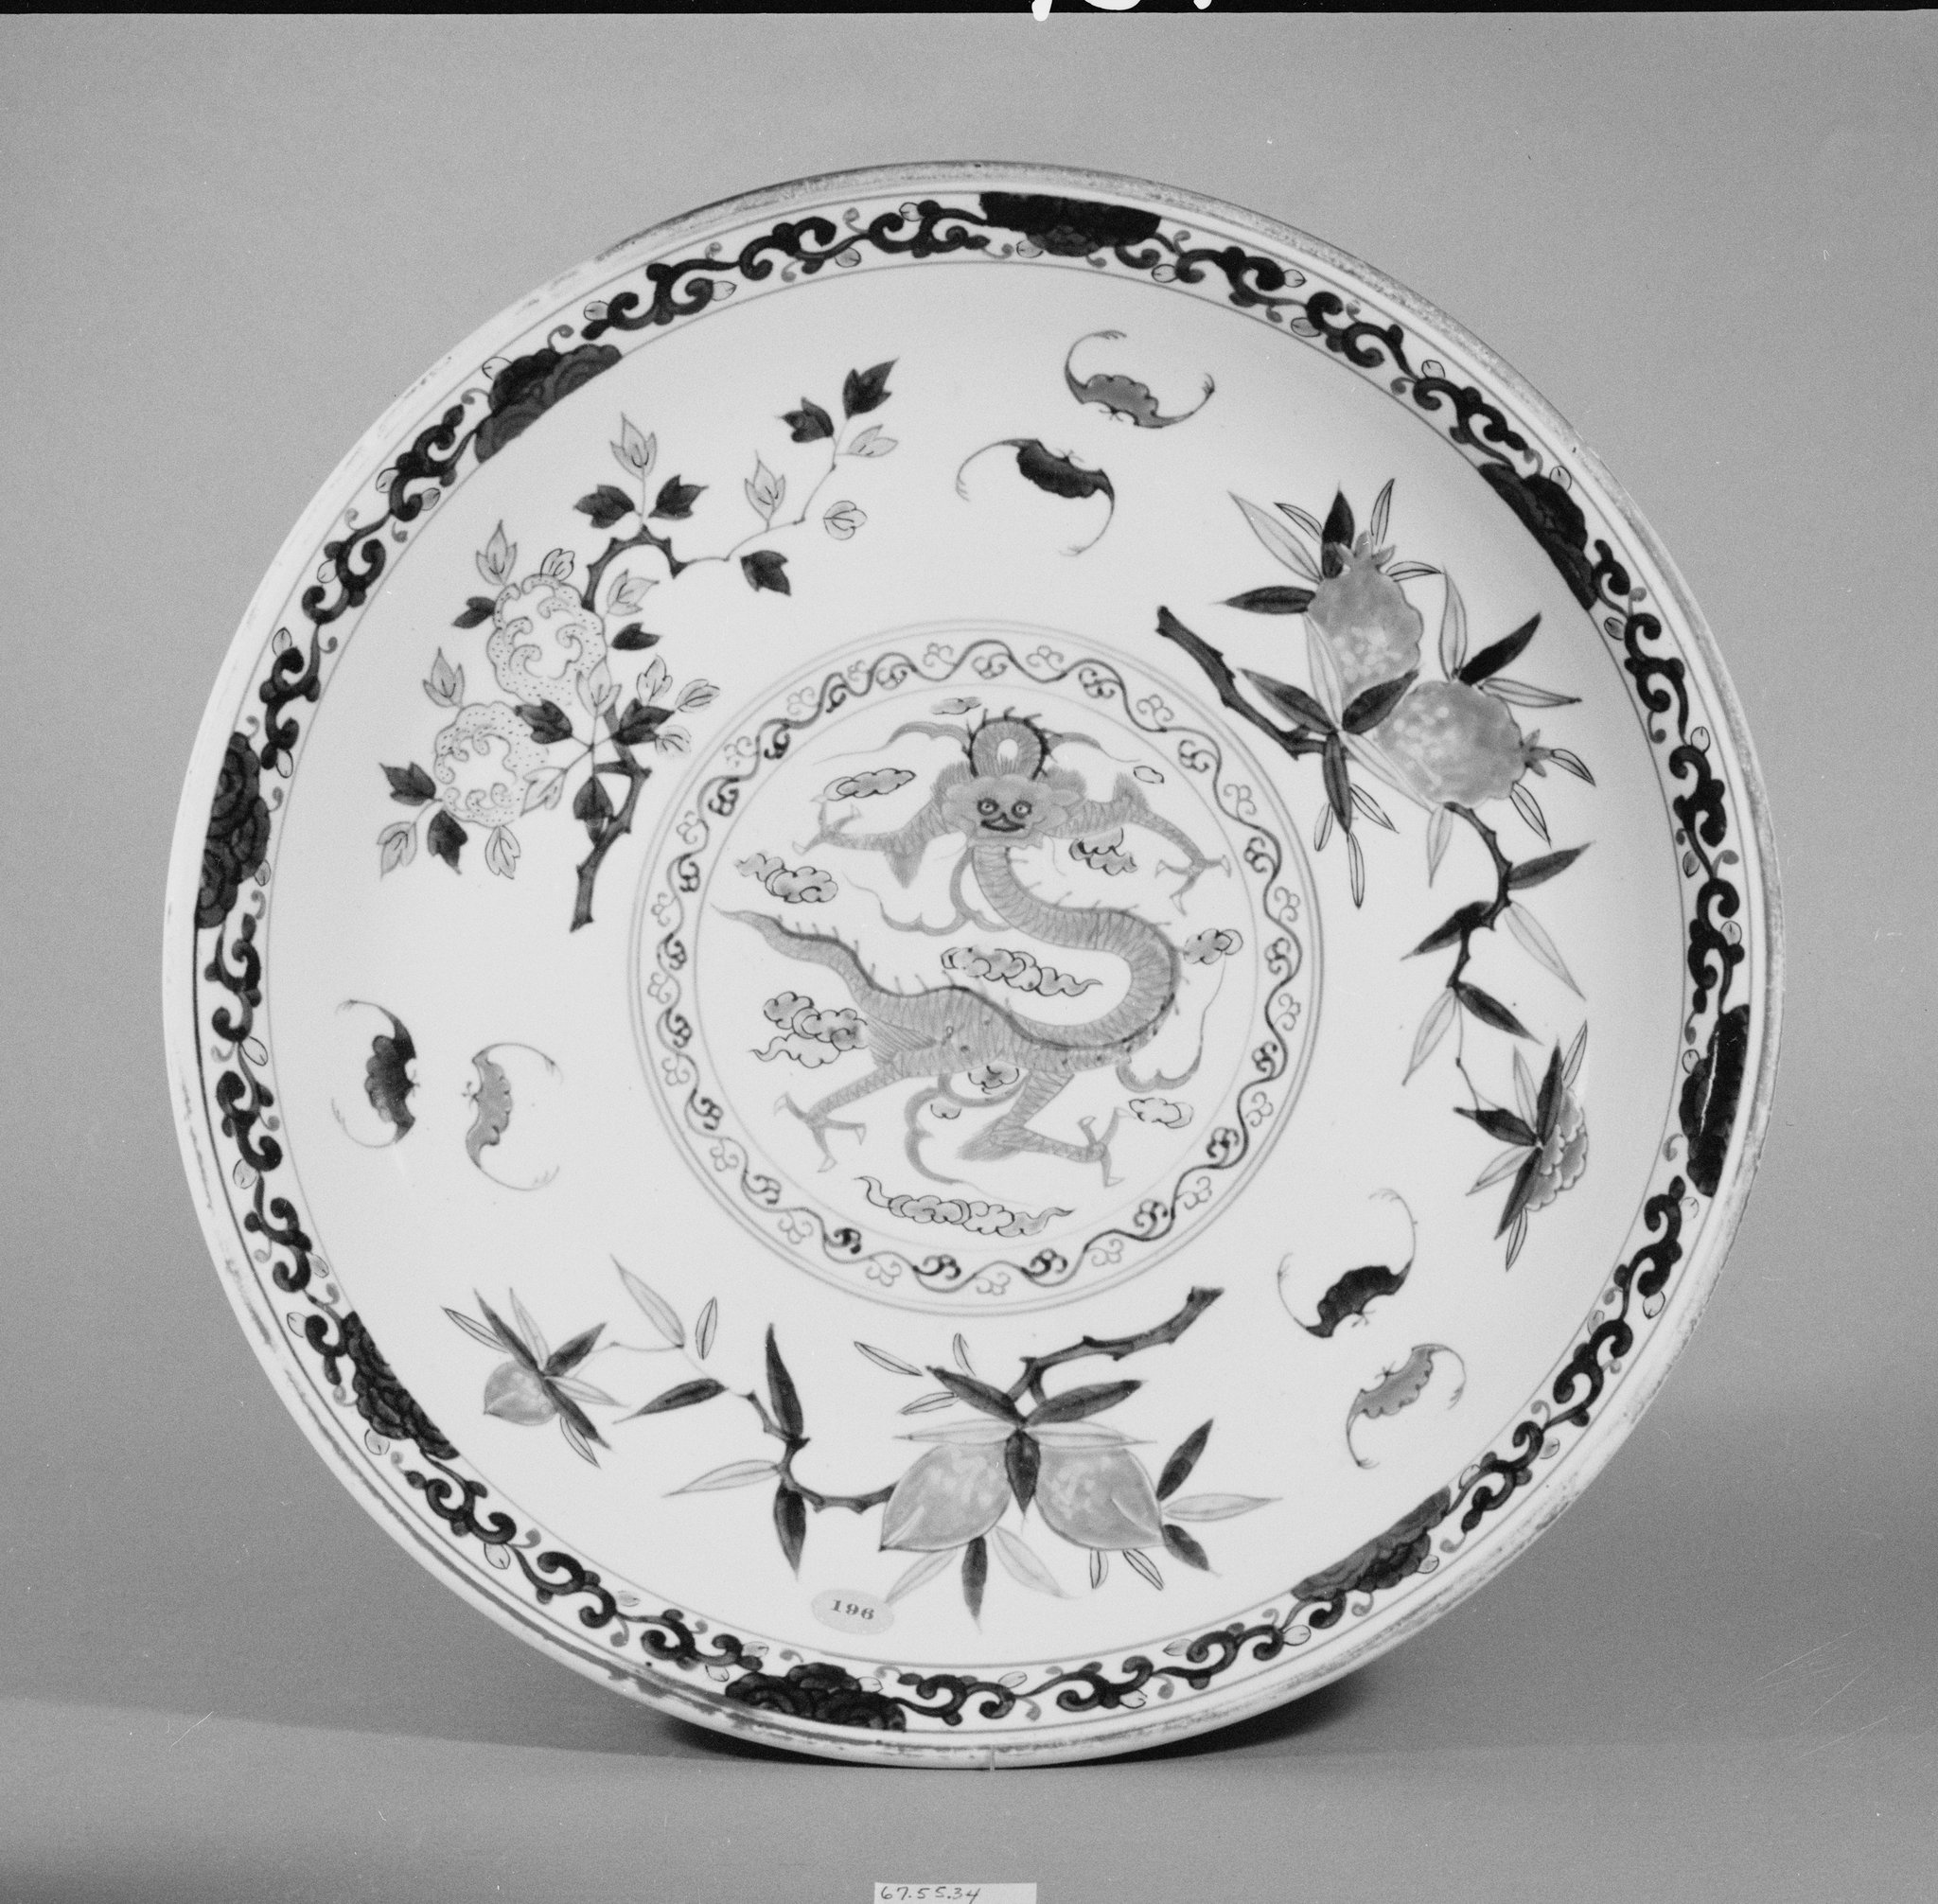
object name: plate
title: Plate (one of a pair)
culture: japanese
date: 1701-1800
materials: enamel, porcelain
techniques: underglaze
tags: dragons